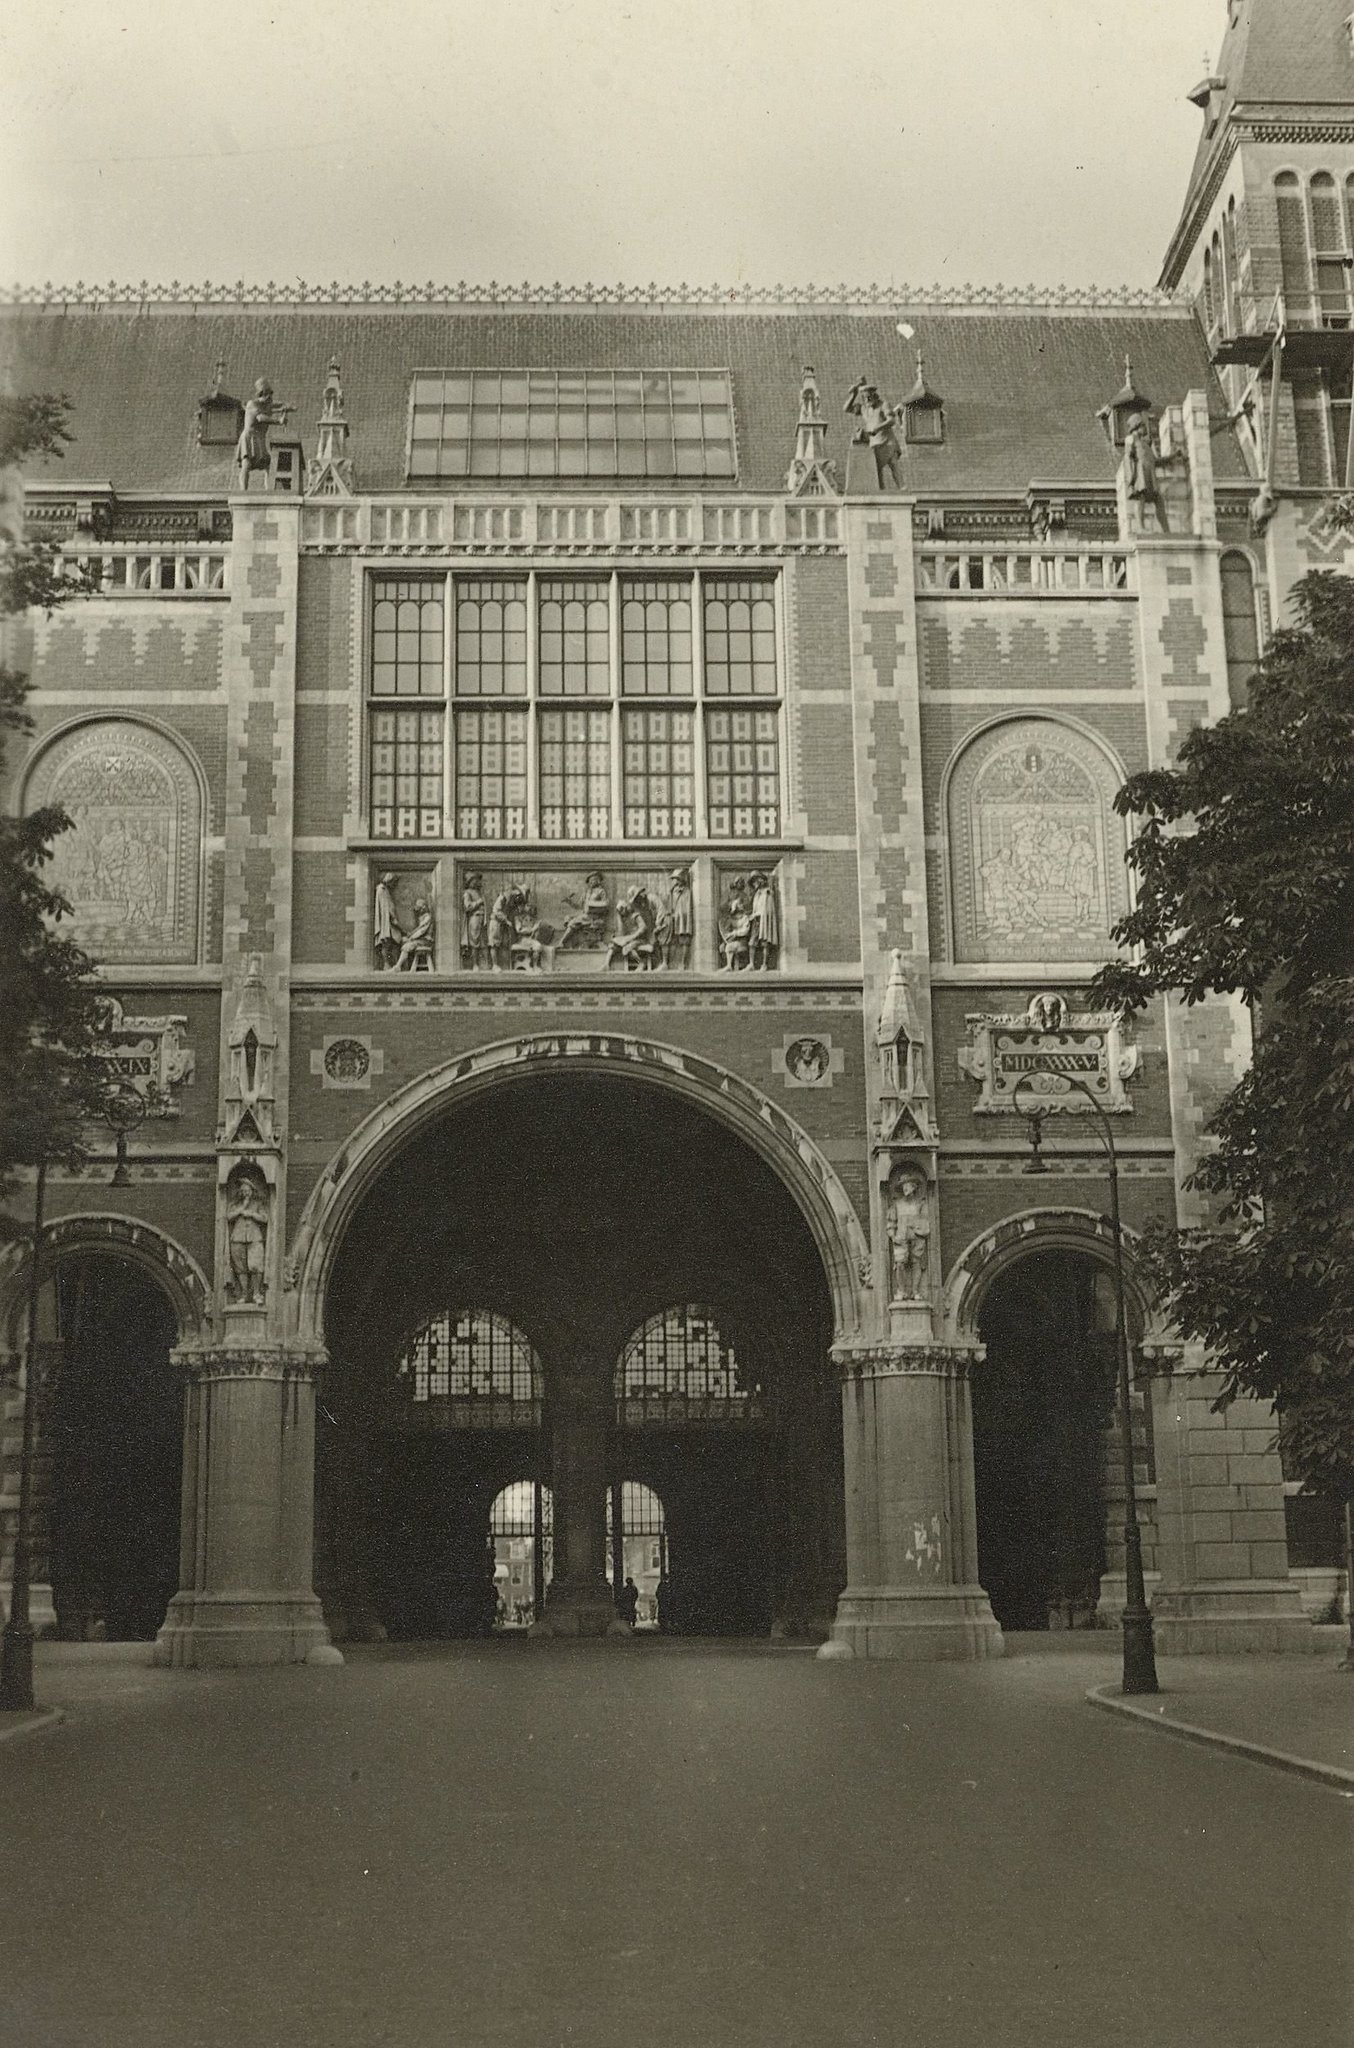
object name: photograph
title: Rijksmuseum Amsterdam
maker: Anonymous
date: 1941-1942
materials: photographic support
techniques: gelatin silver print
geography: amsterdam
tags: rijksmuseum amsterdam, permanent exhibition, museum, occupation ~ war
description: Het Rijksmuseum: de onderdoorgang gezien vanaf het Museumplein. Achterop staat: Amsterdam Museumsportal.